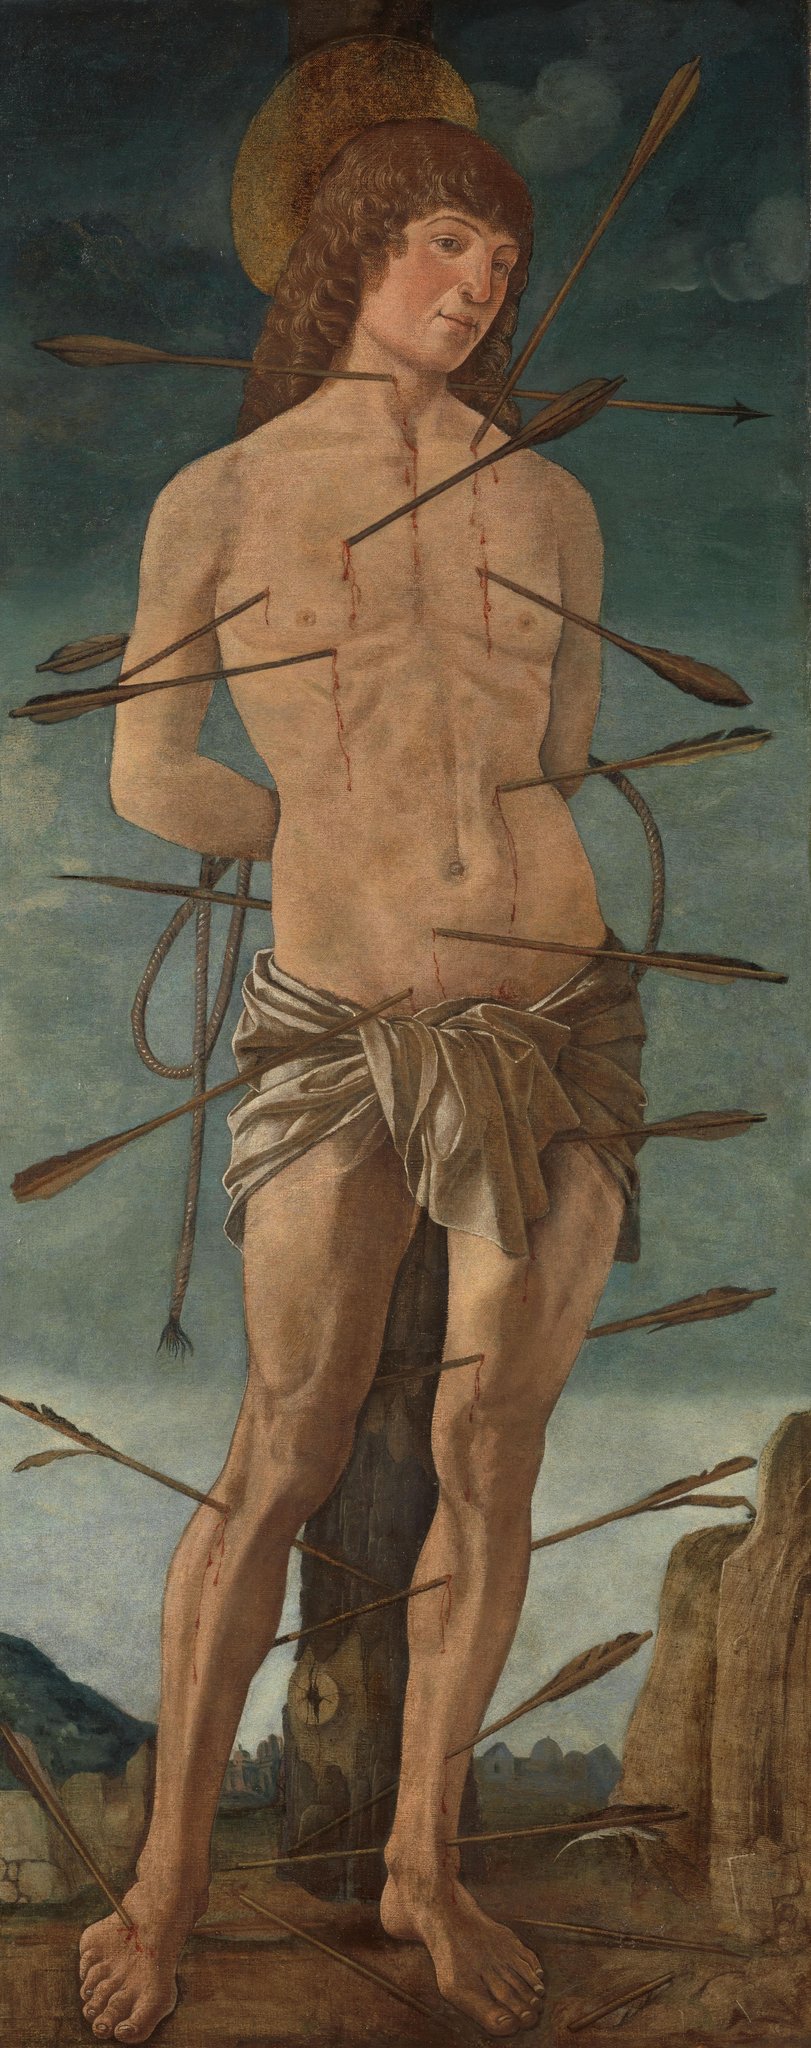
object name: painting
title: St Sebastian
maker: francesco bonsignori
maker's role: painter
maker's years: 1455-1519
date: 1470-1490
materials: canvas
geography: mantua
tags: martyrdom, suffering, misfortune, death of st. sebastian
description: De heilige Sebastiaan, gebonden aan een paal, met pijlen doorboord.